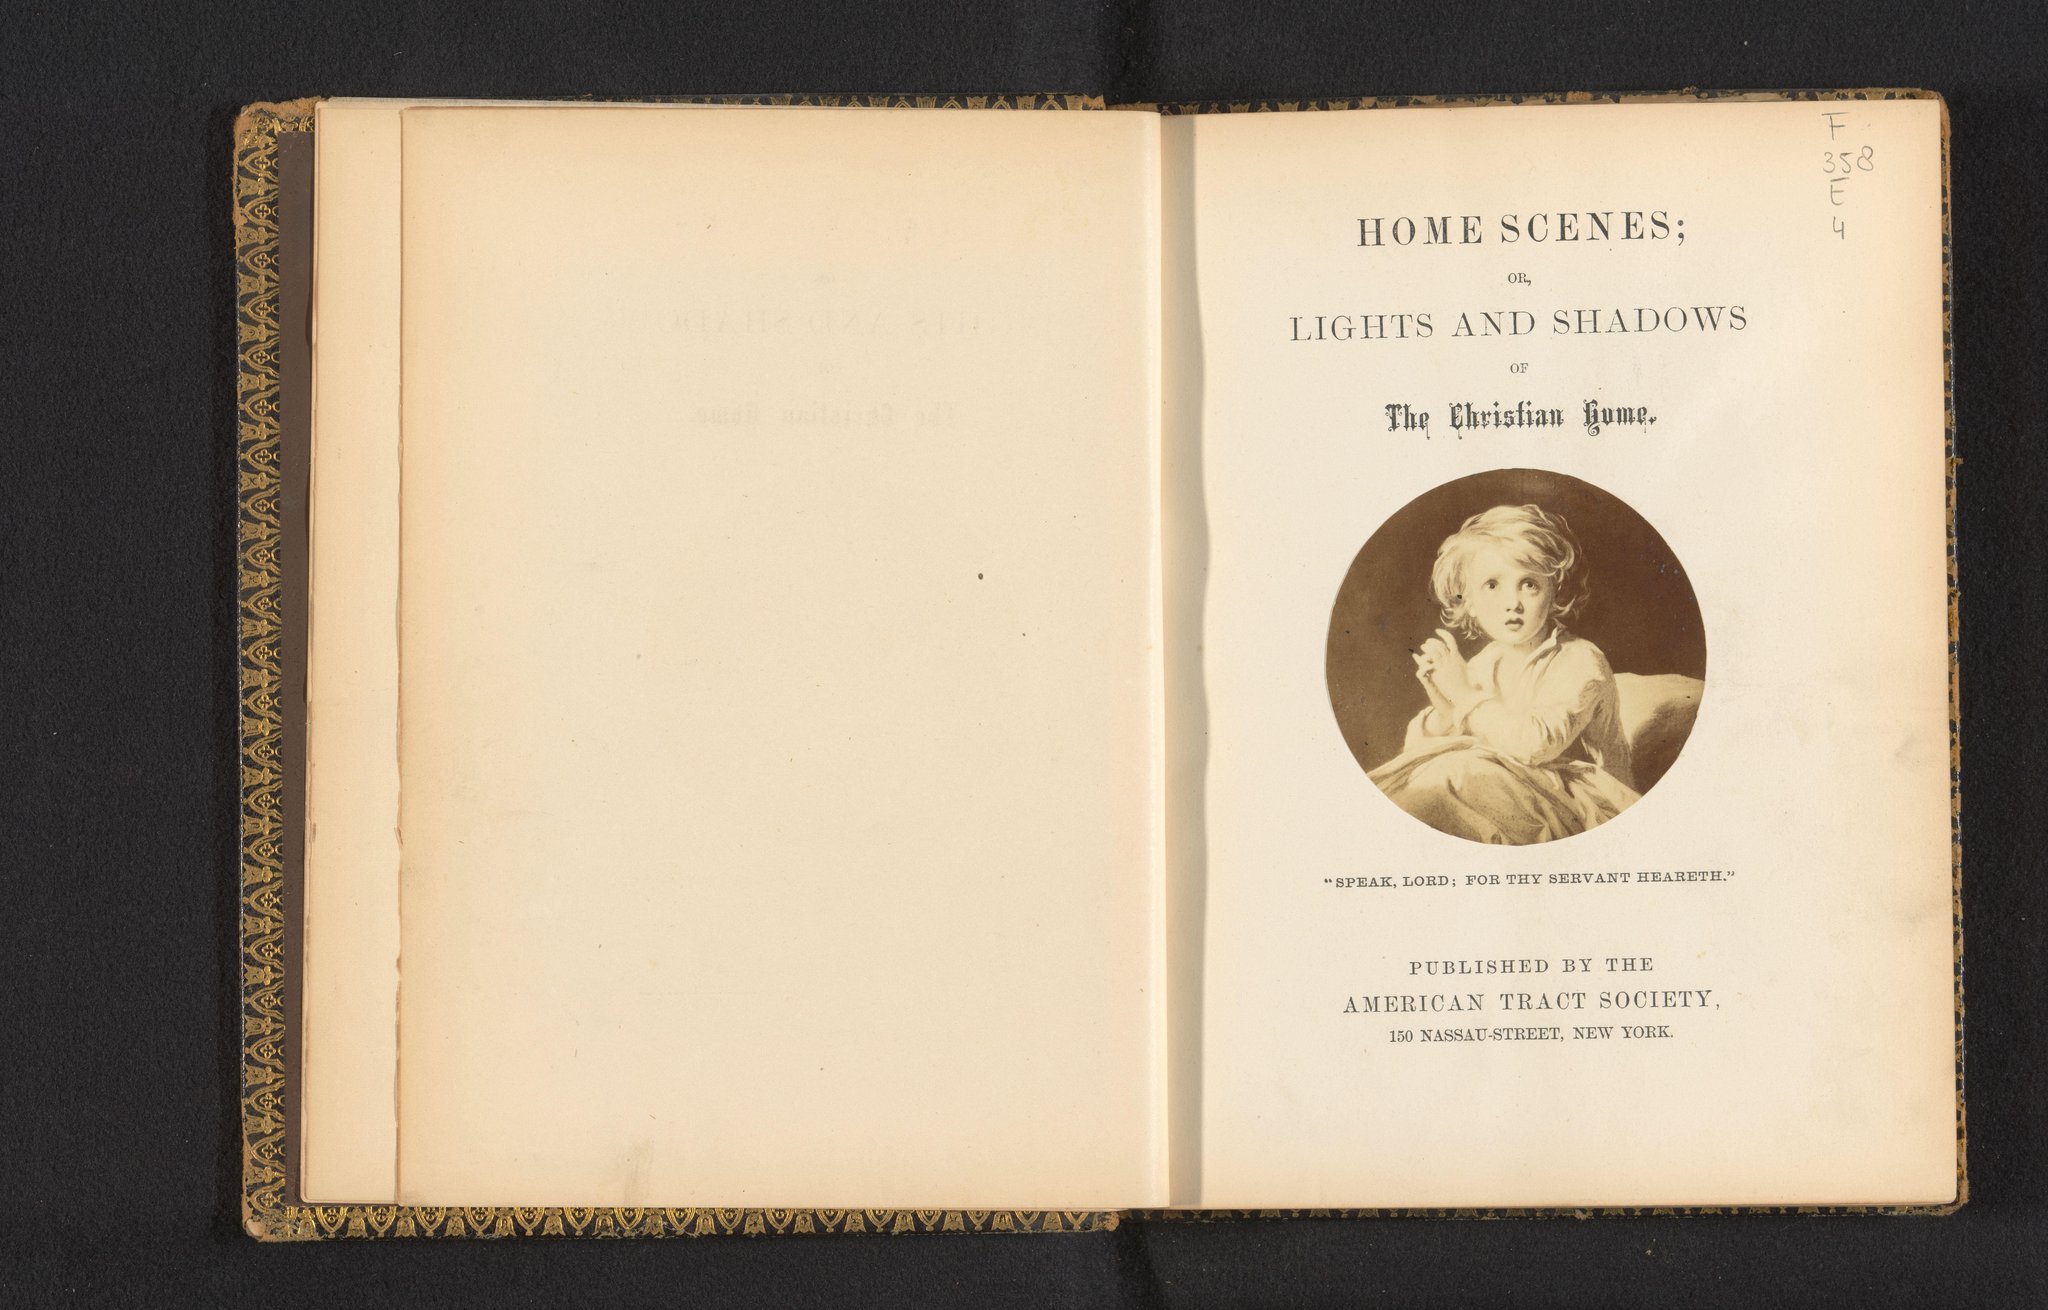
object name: book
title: Home scenes, or, lights and shadows of the Christian home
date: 1865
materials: cardboard, leather, paper, photographic support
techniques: albumen print, printing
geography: new york city